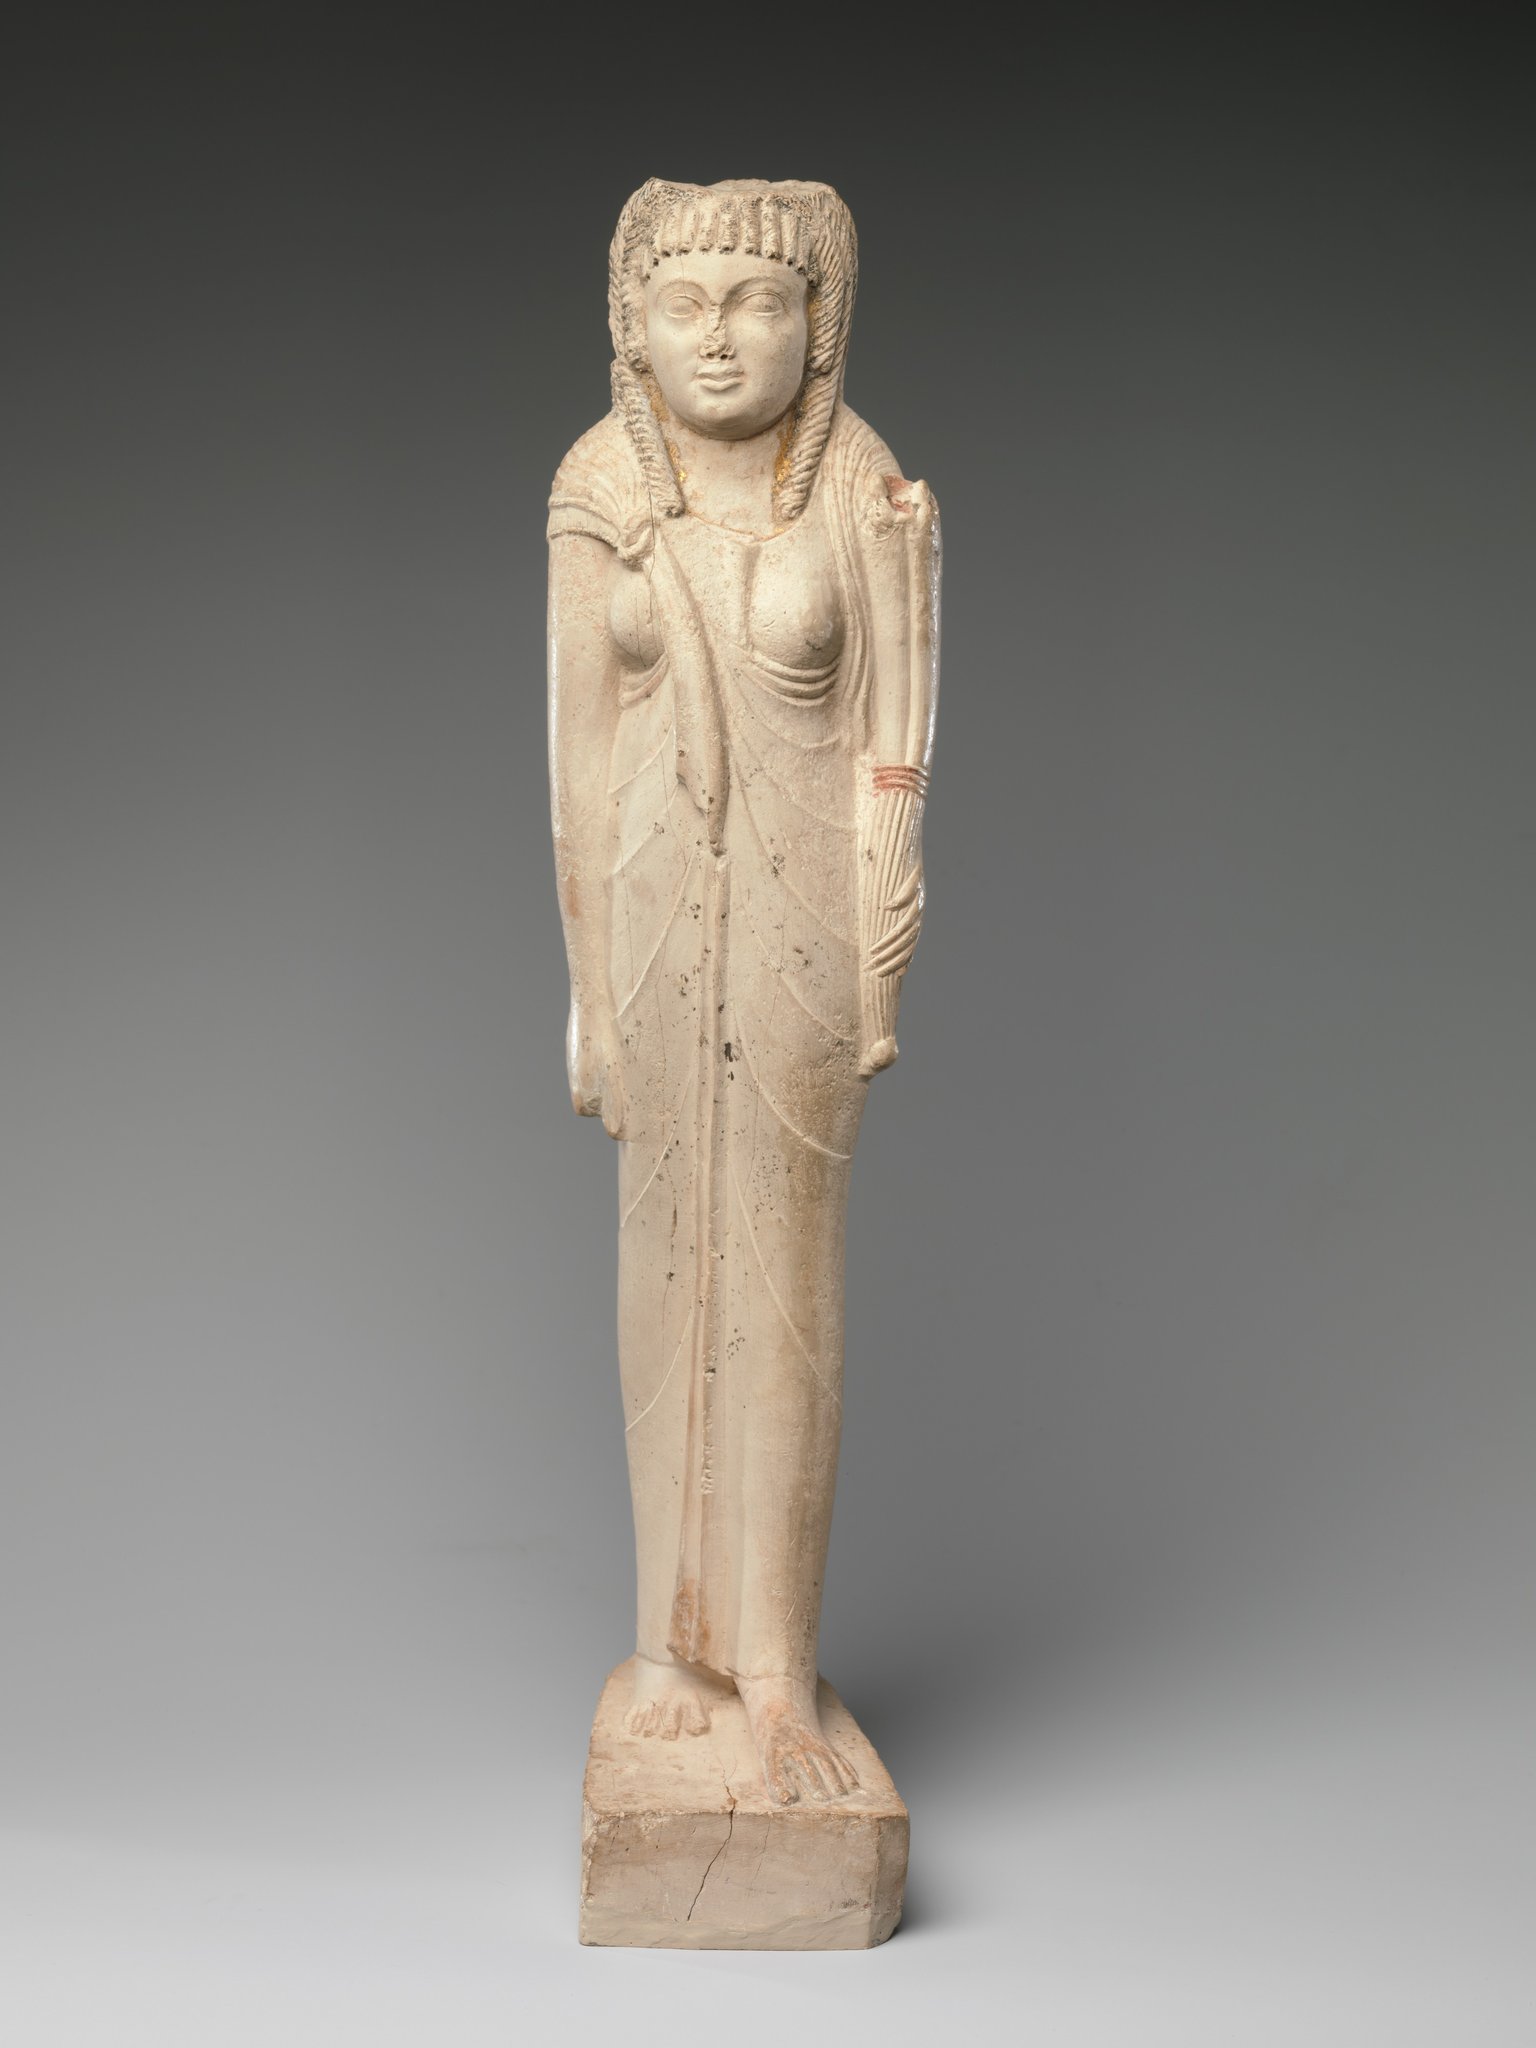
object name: statuette, standing queen, arsinoe ii, deified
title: Statuette of Arsinoe II for her Posthumous Cult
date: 150-100 BCE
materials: gold leaf, limestone, paint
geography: egypt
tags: goddess